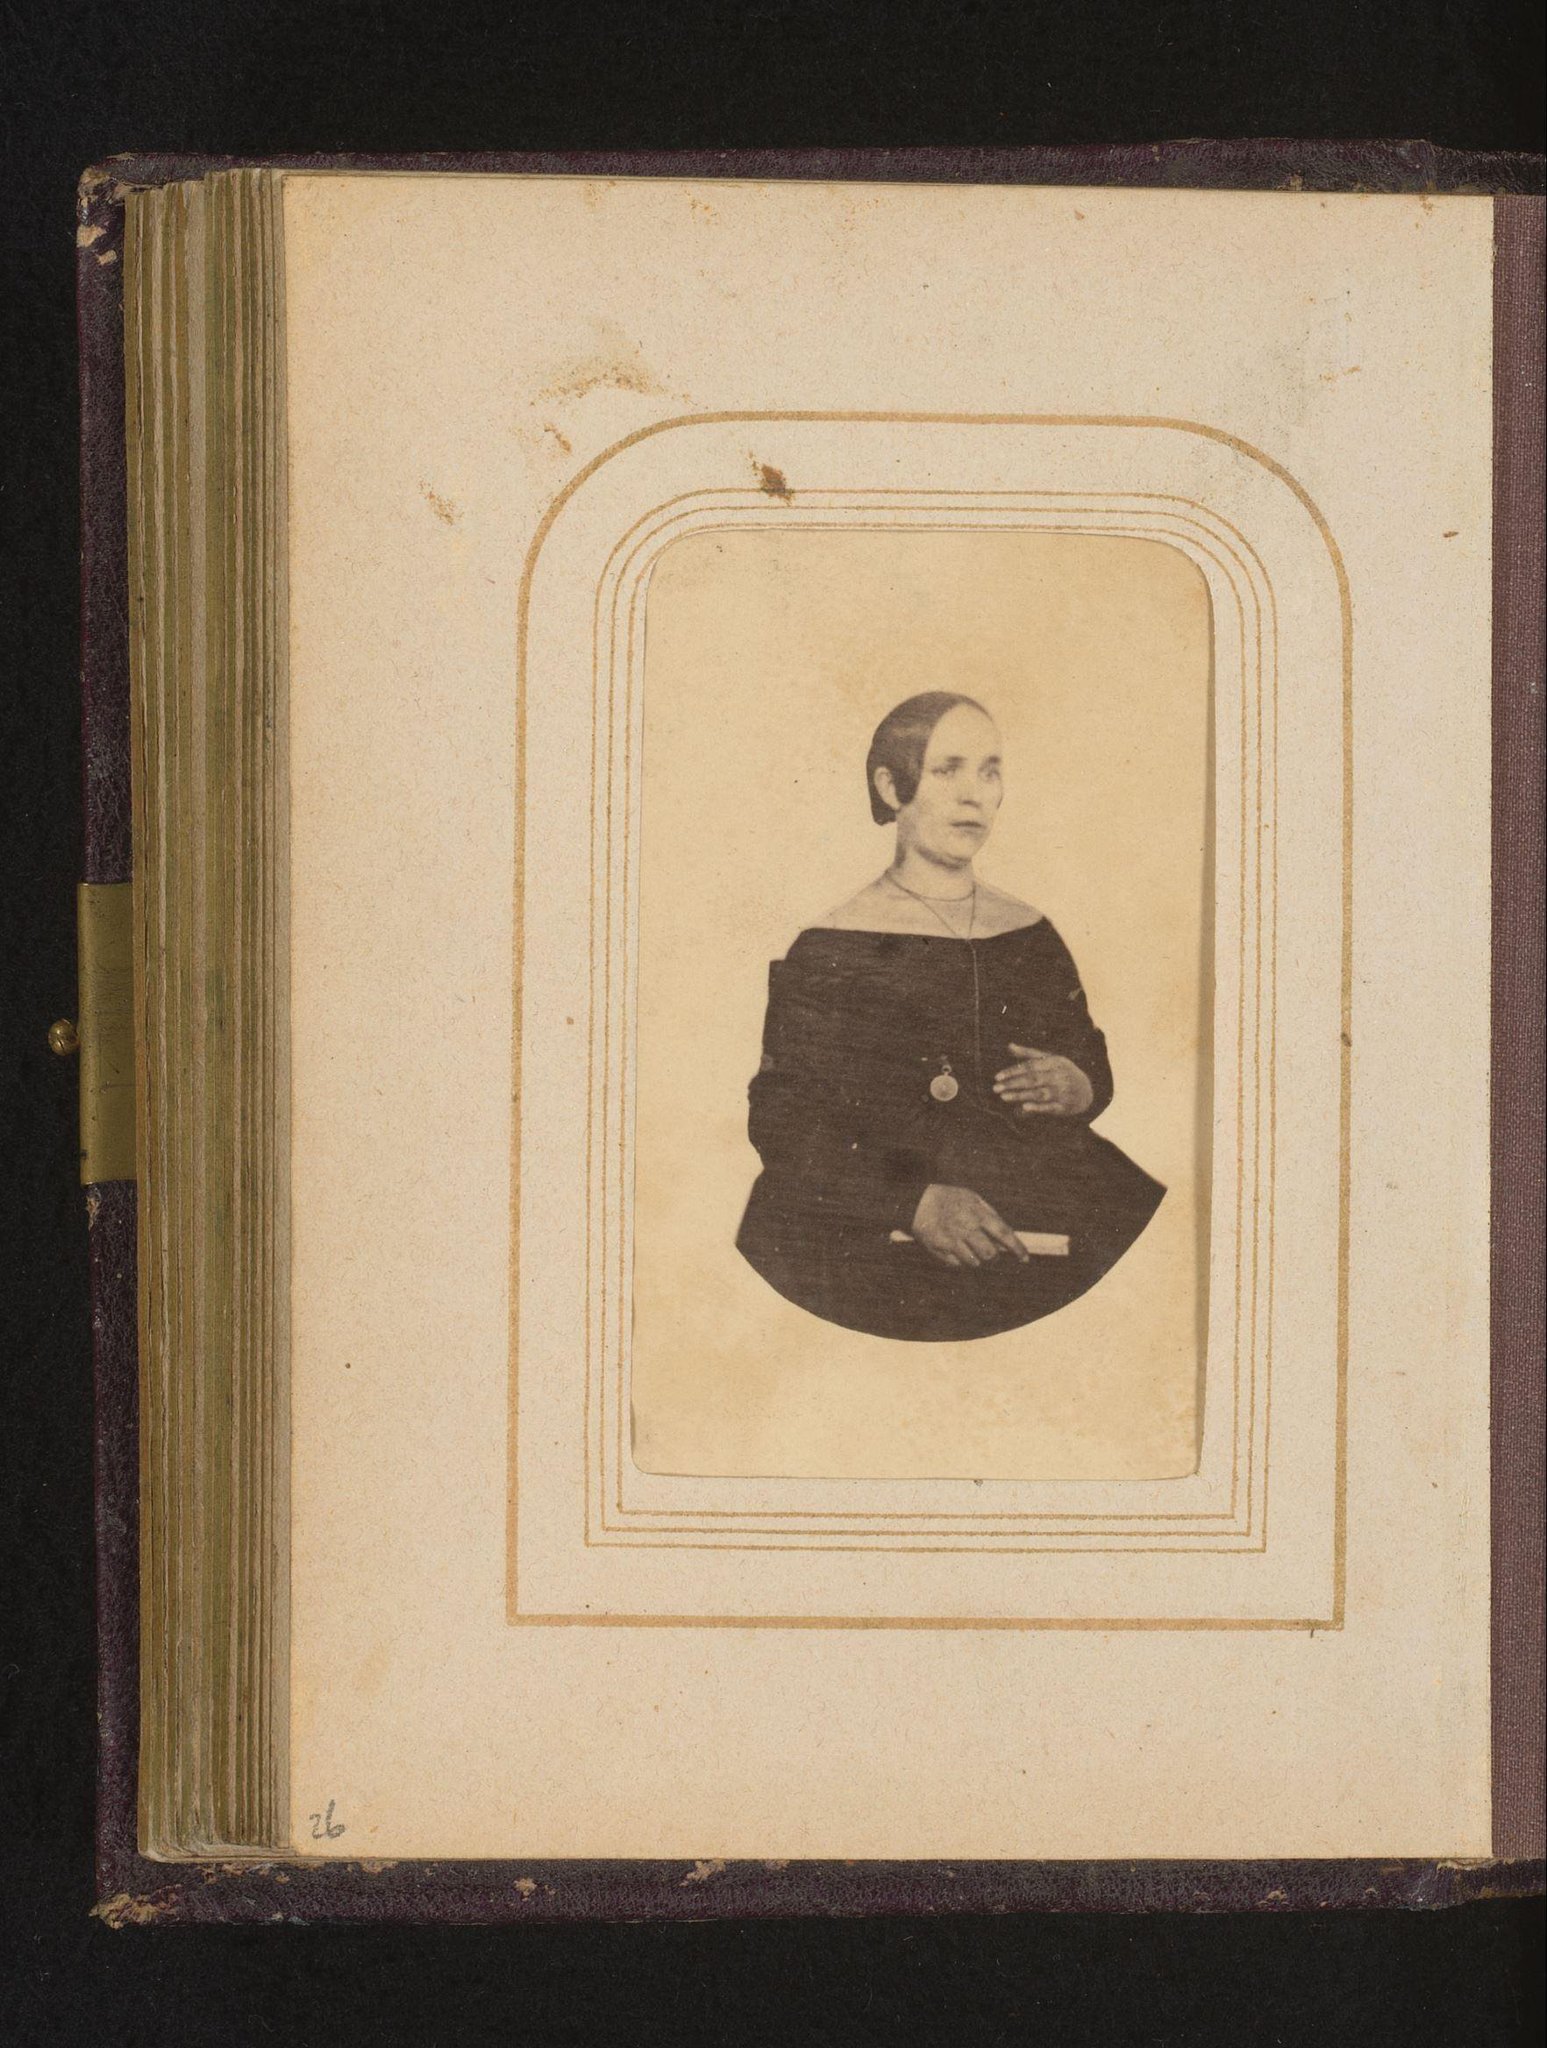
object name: carte de visite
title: Portret van een zittende vrouw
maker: Anonymous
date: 1860-1900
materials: cardboard, photographic support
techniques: albumen print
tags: historical persons - bb - woman